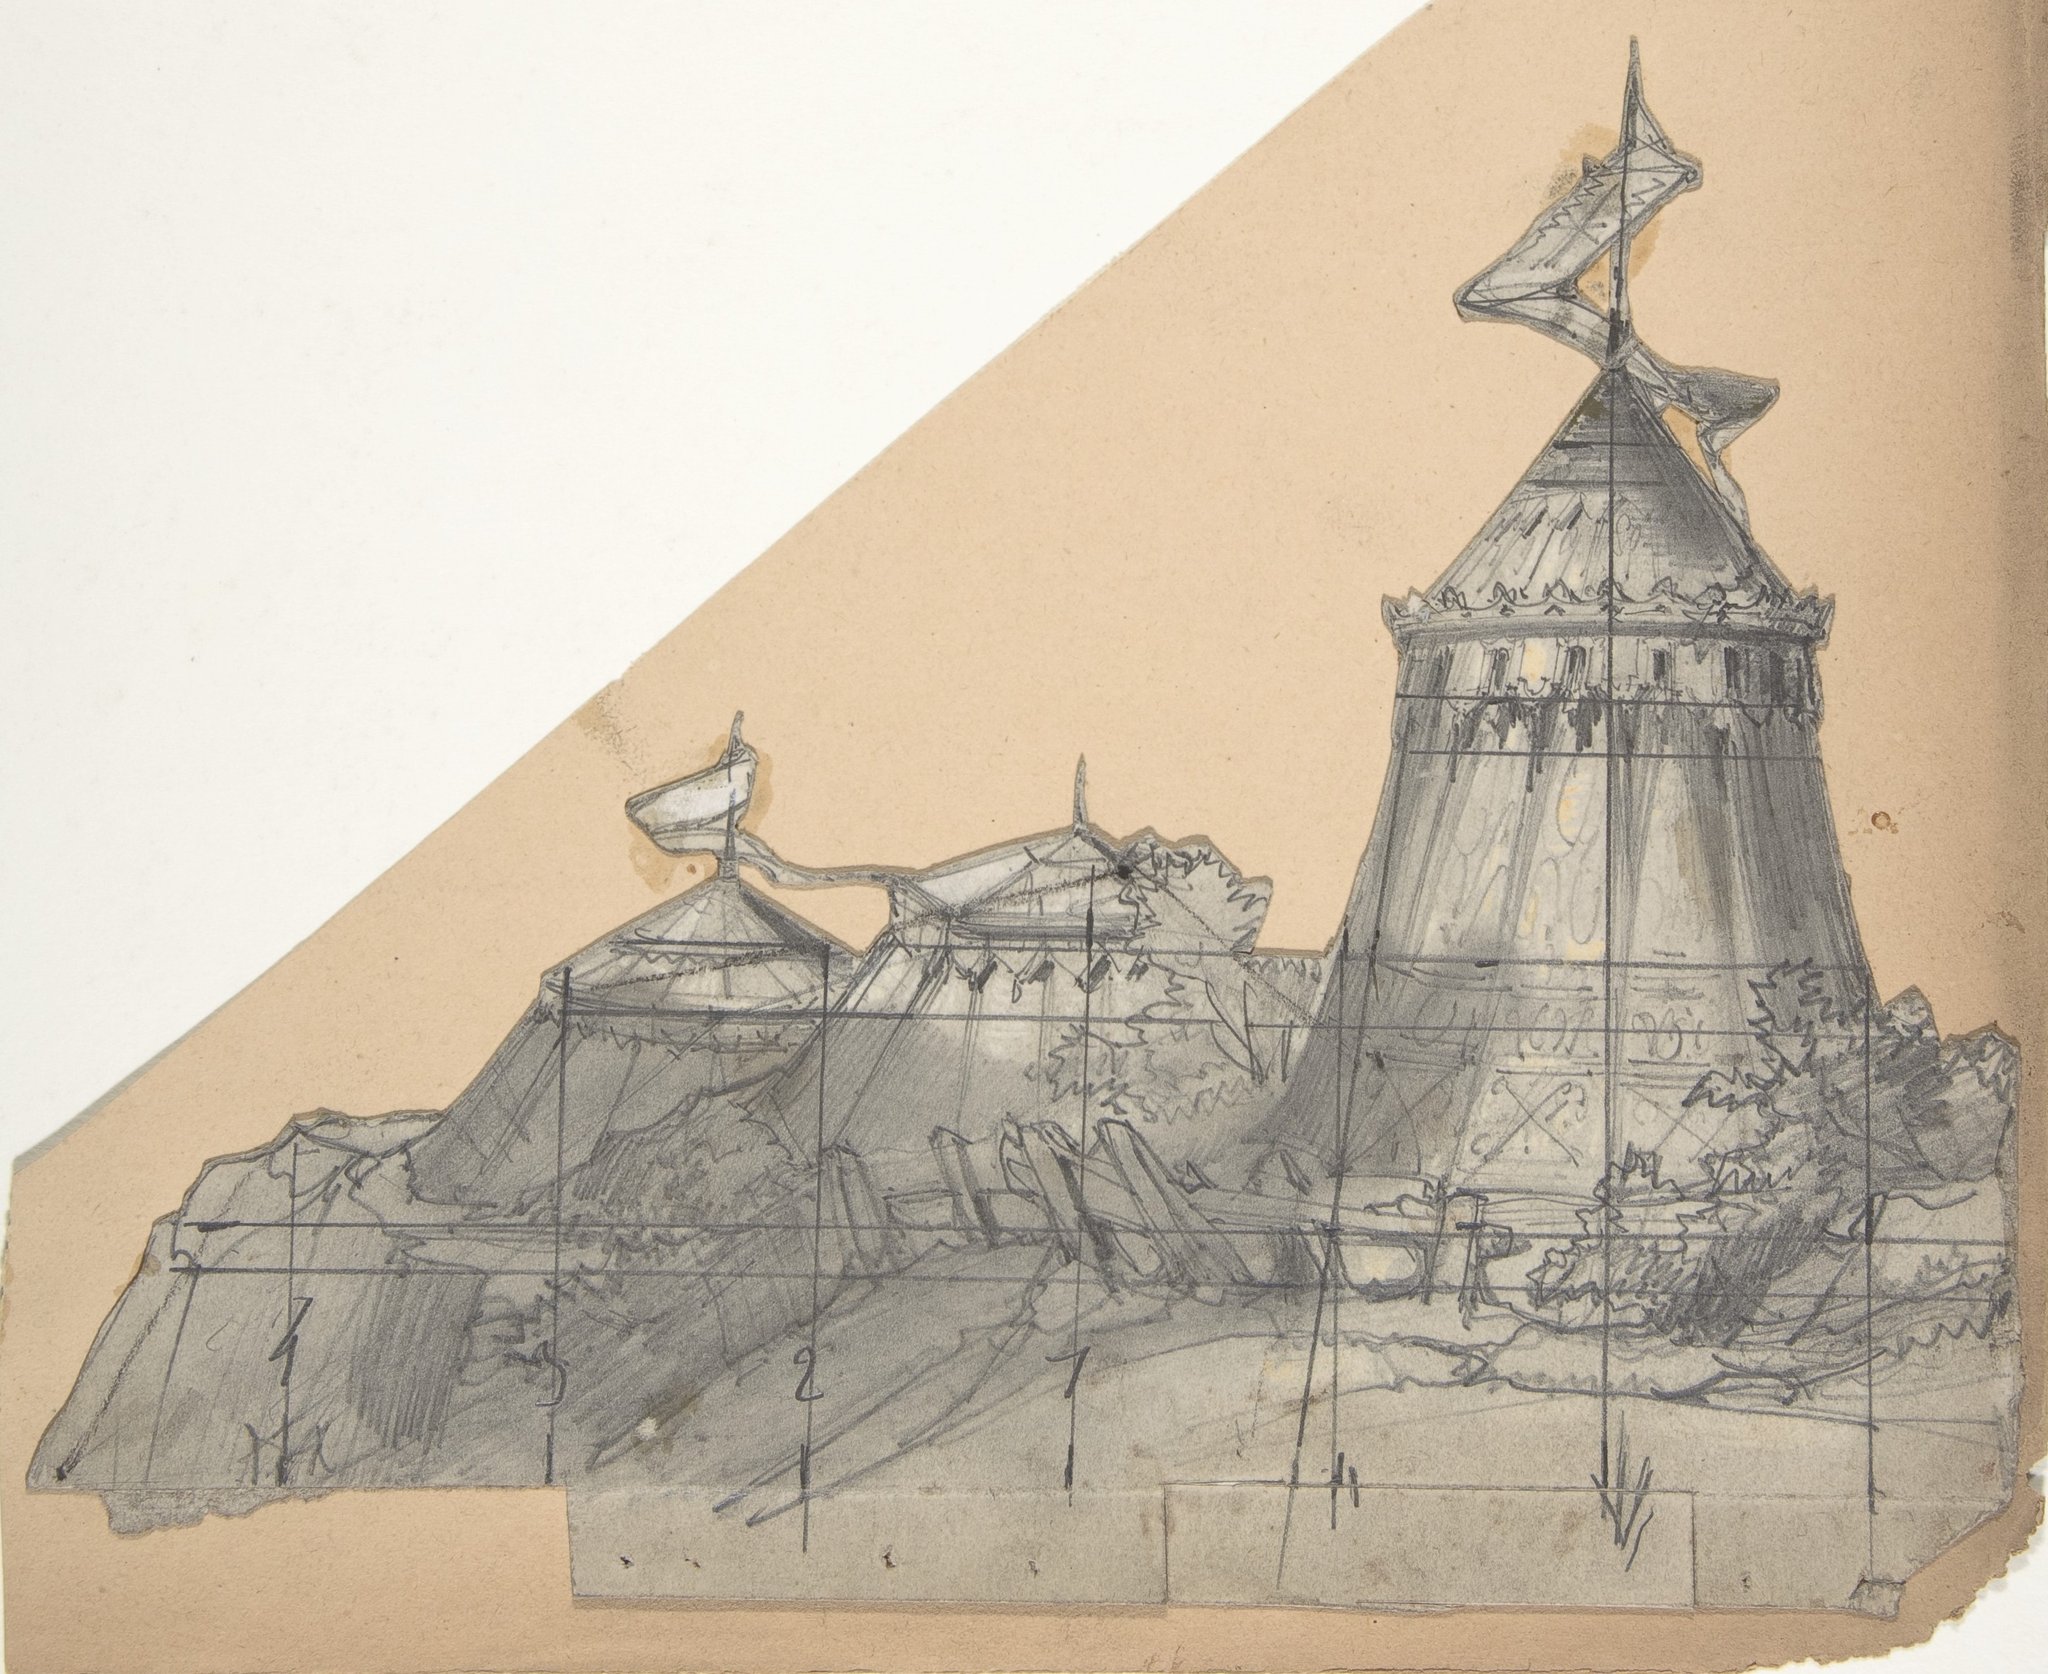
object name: drawing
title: Design for a Stage Set at the Opéra, Paris: A Tent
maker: eugène cicéri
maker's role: artist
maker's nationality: french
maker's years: 1813-1890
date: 1830-1890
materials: graphite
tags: tents,stage design